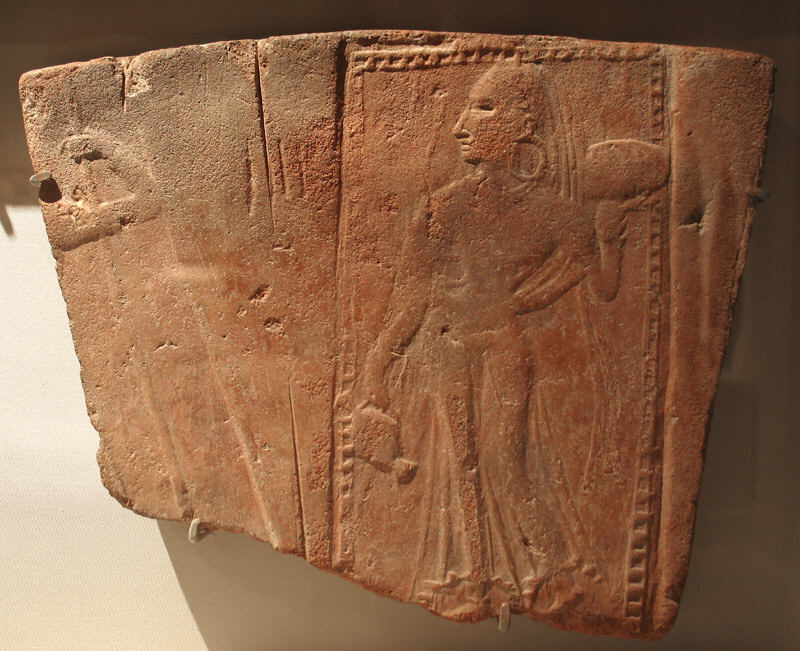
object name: tile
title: Tile showing a woman carrying a pot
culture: india, kashmir, harwan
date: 401-600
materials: terracotta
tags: kashmir,women